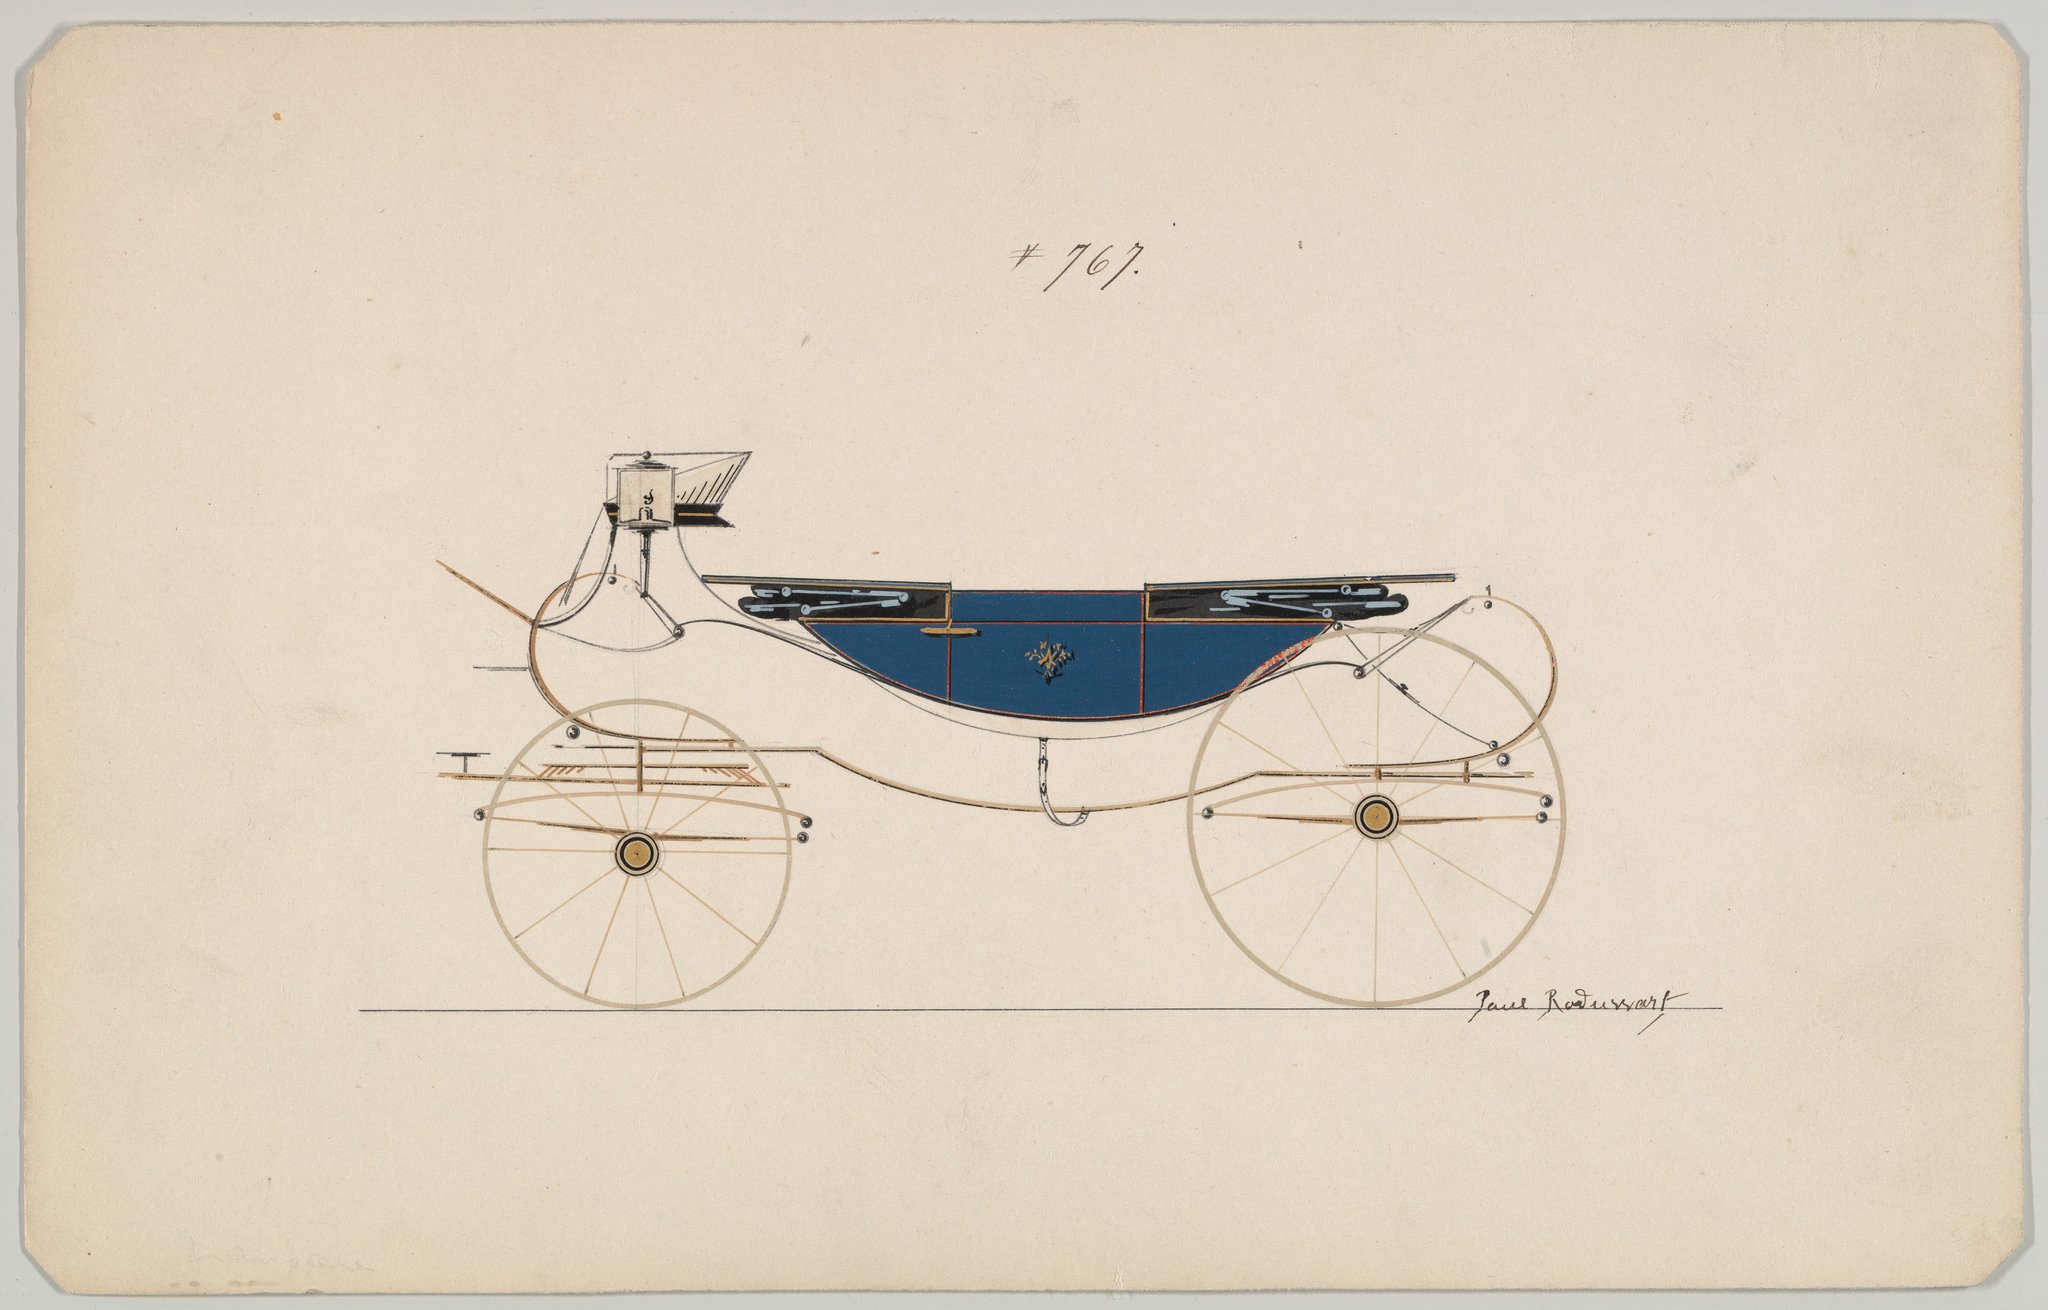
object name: drawing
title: Landau #767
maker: brewster & co.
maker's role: manufacturer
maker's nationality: american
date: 1850-1870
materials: gouache, ink, watercolor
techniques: pen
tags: carriages